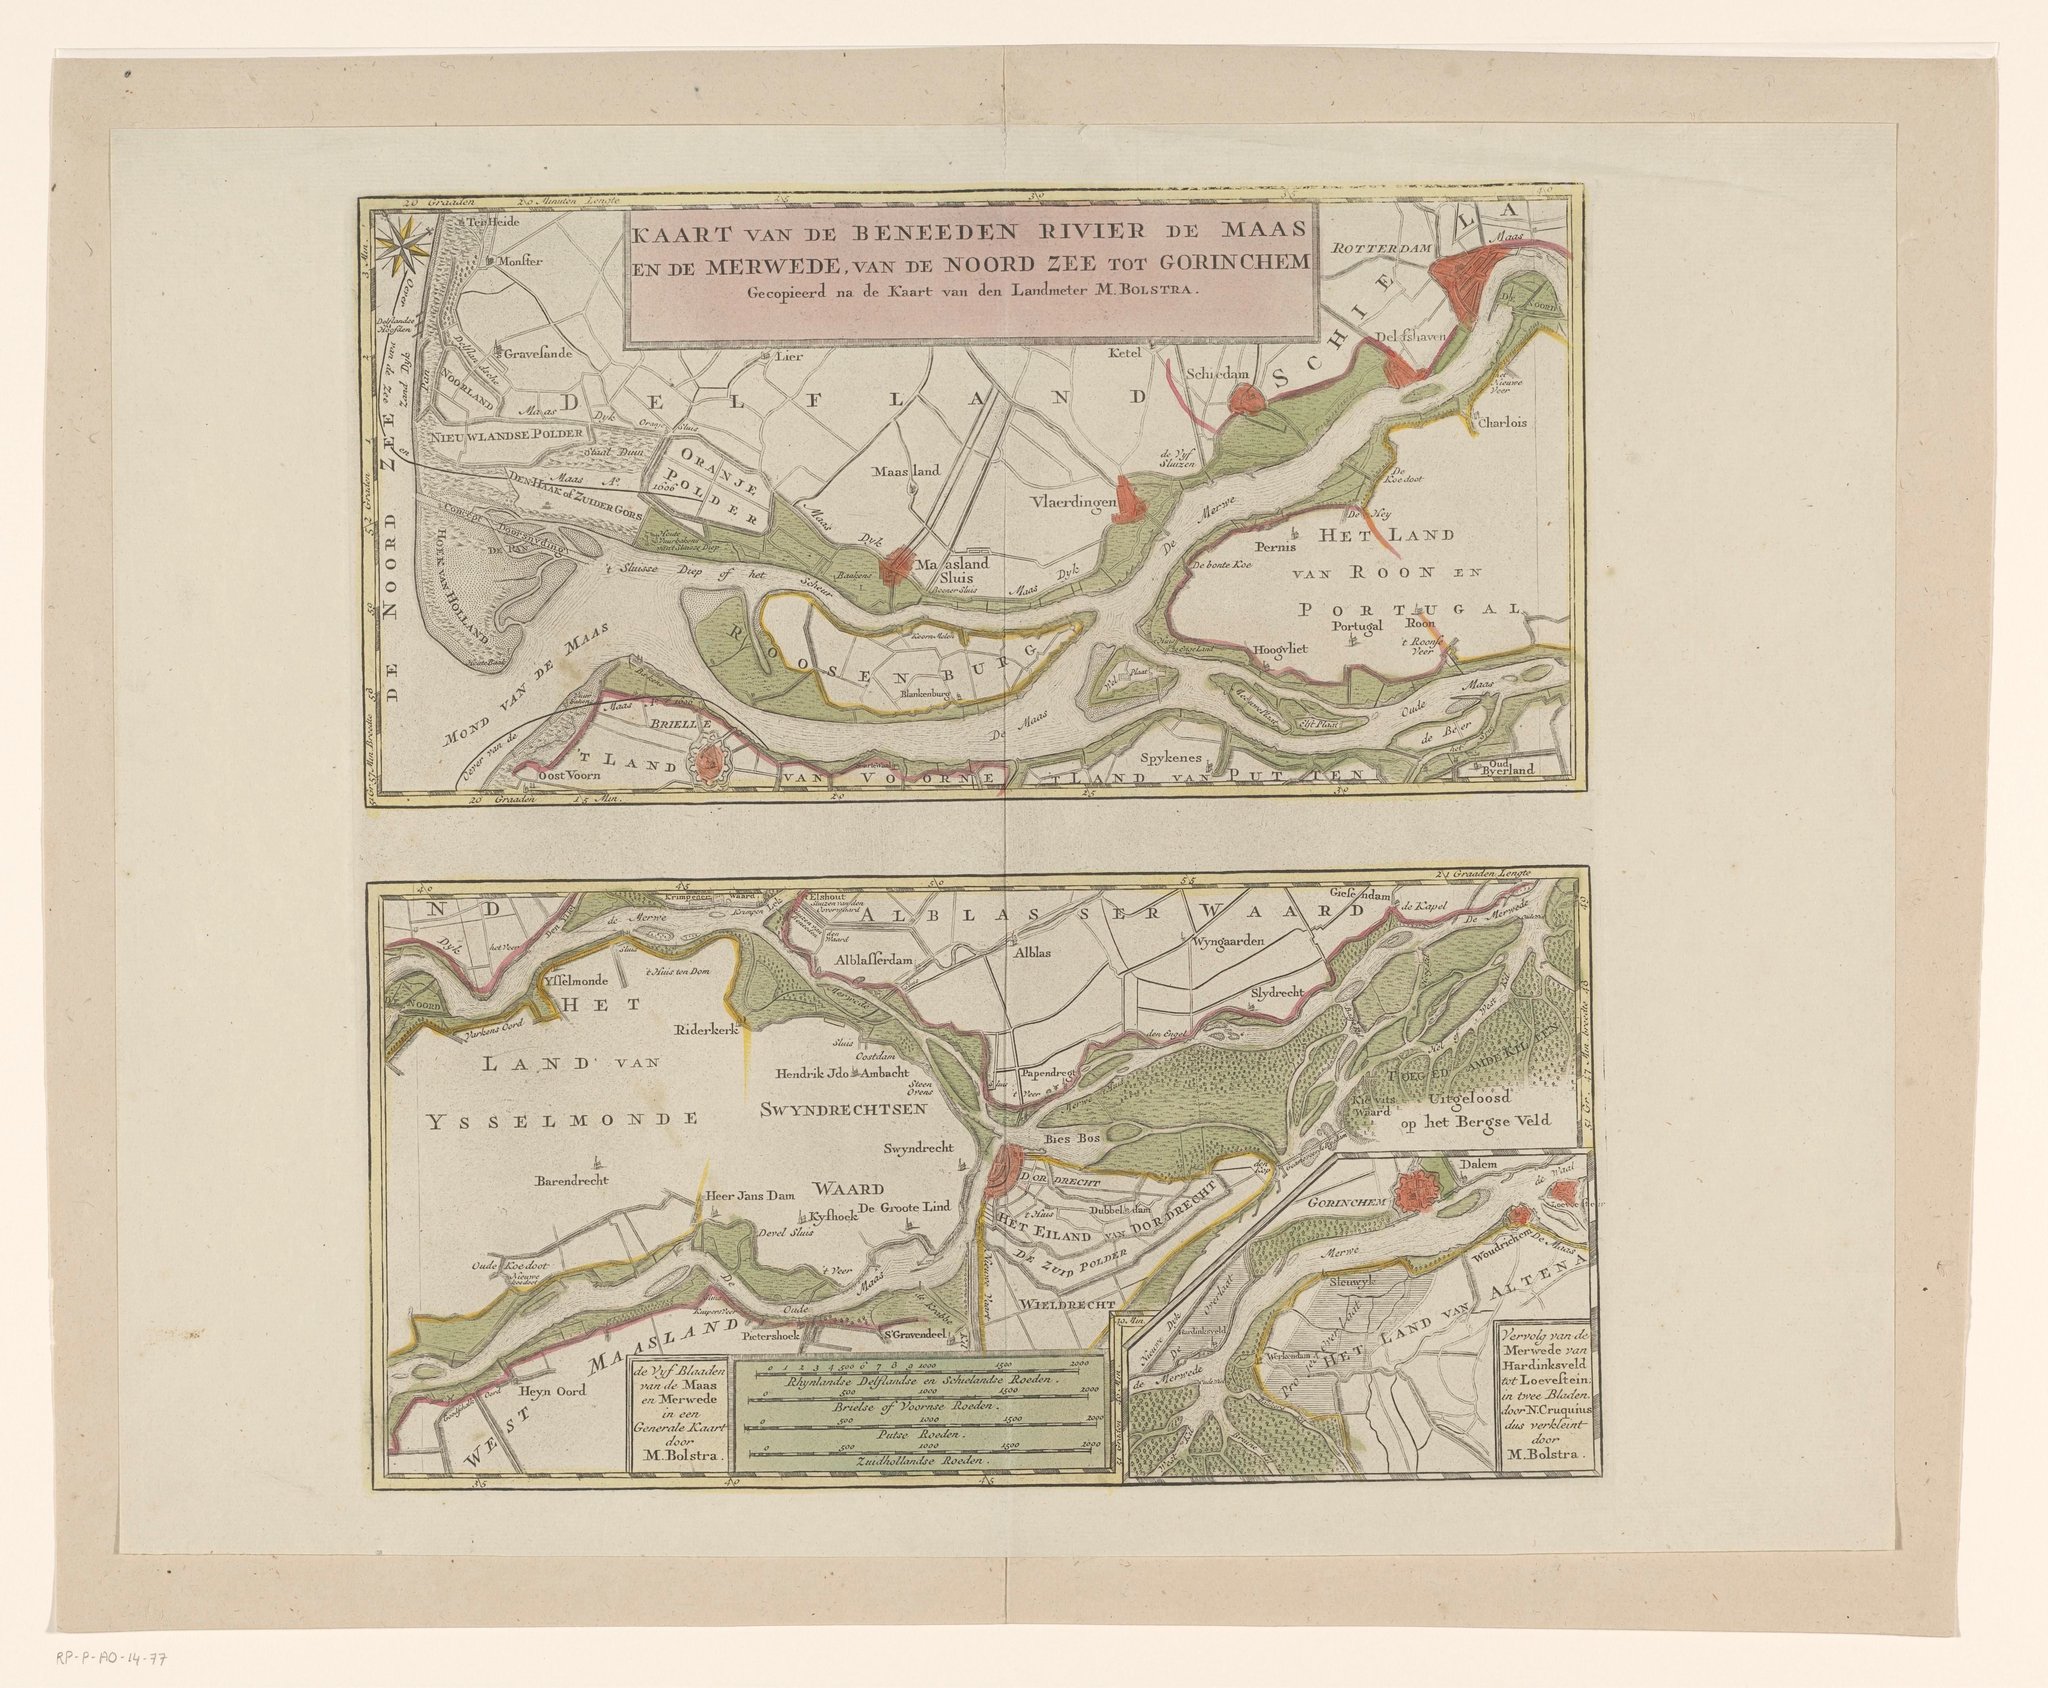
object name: print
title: Kaart van de Maas en de Merwede van de Noordzee tot Gorinchem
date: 1749-1769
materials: paper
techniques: engraving, etching, hand coloring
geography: amsterdam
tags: maps of separate countries or regions, gelderland